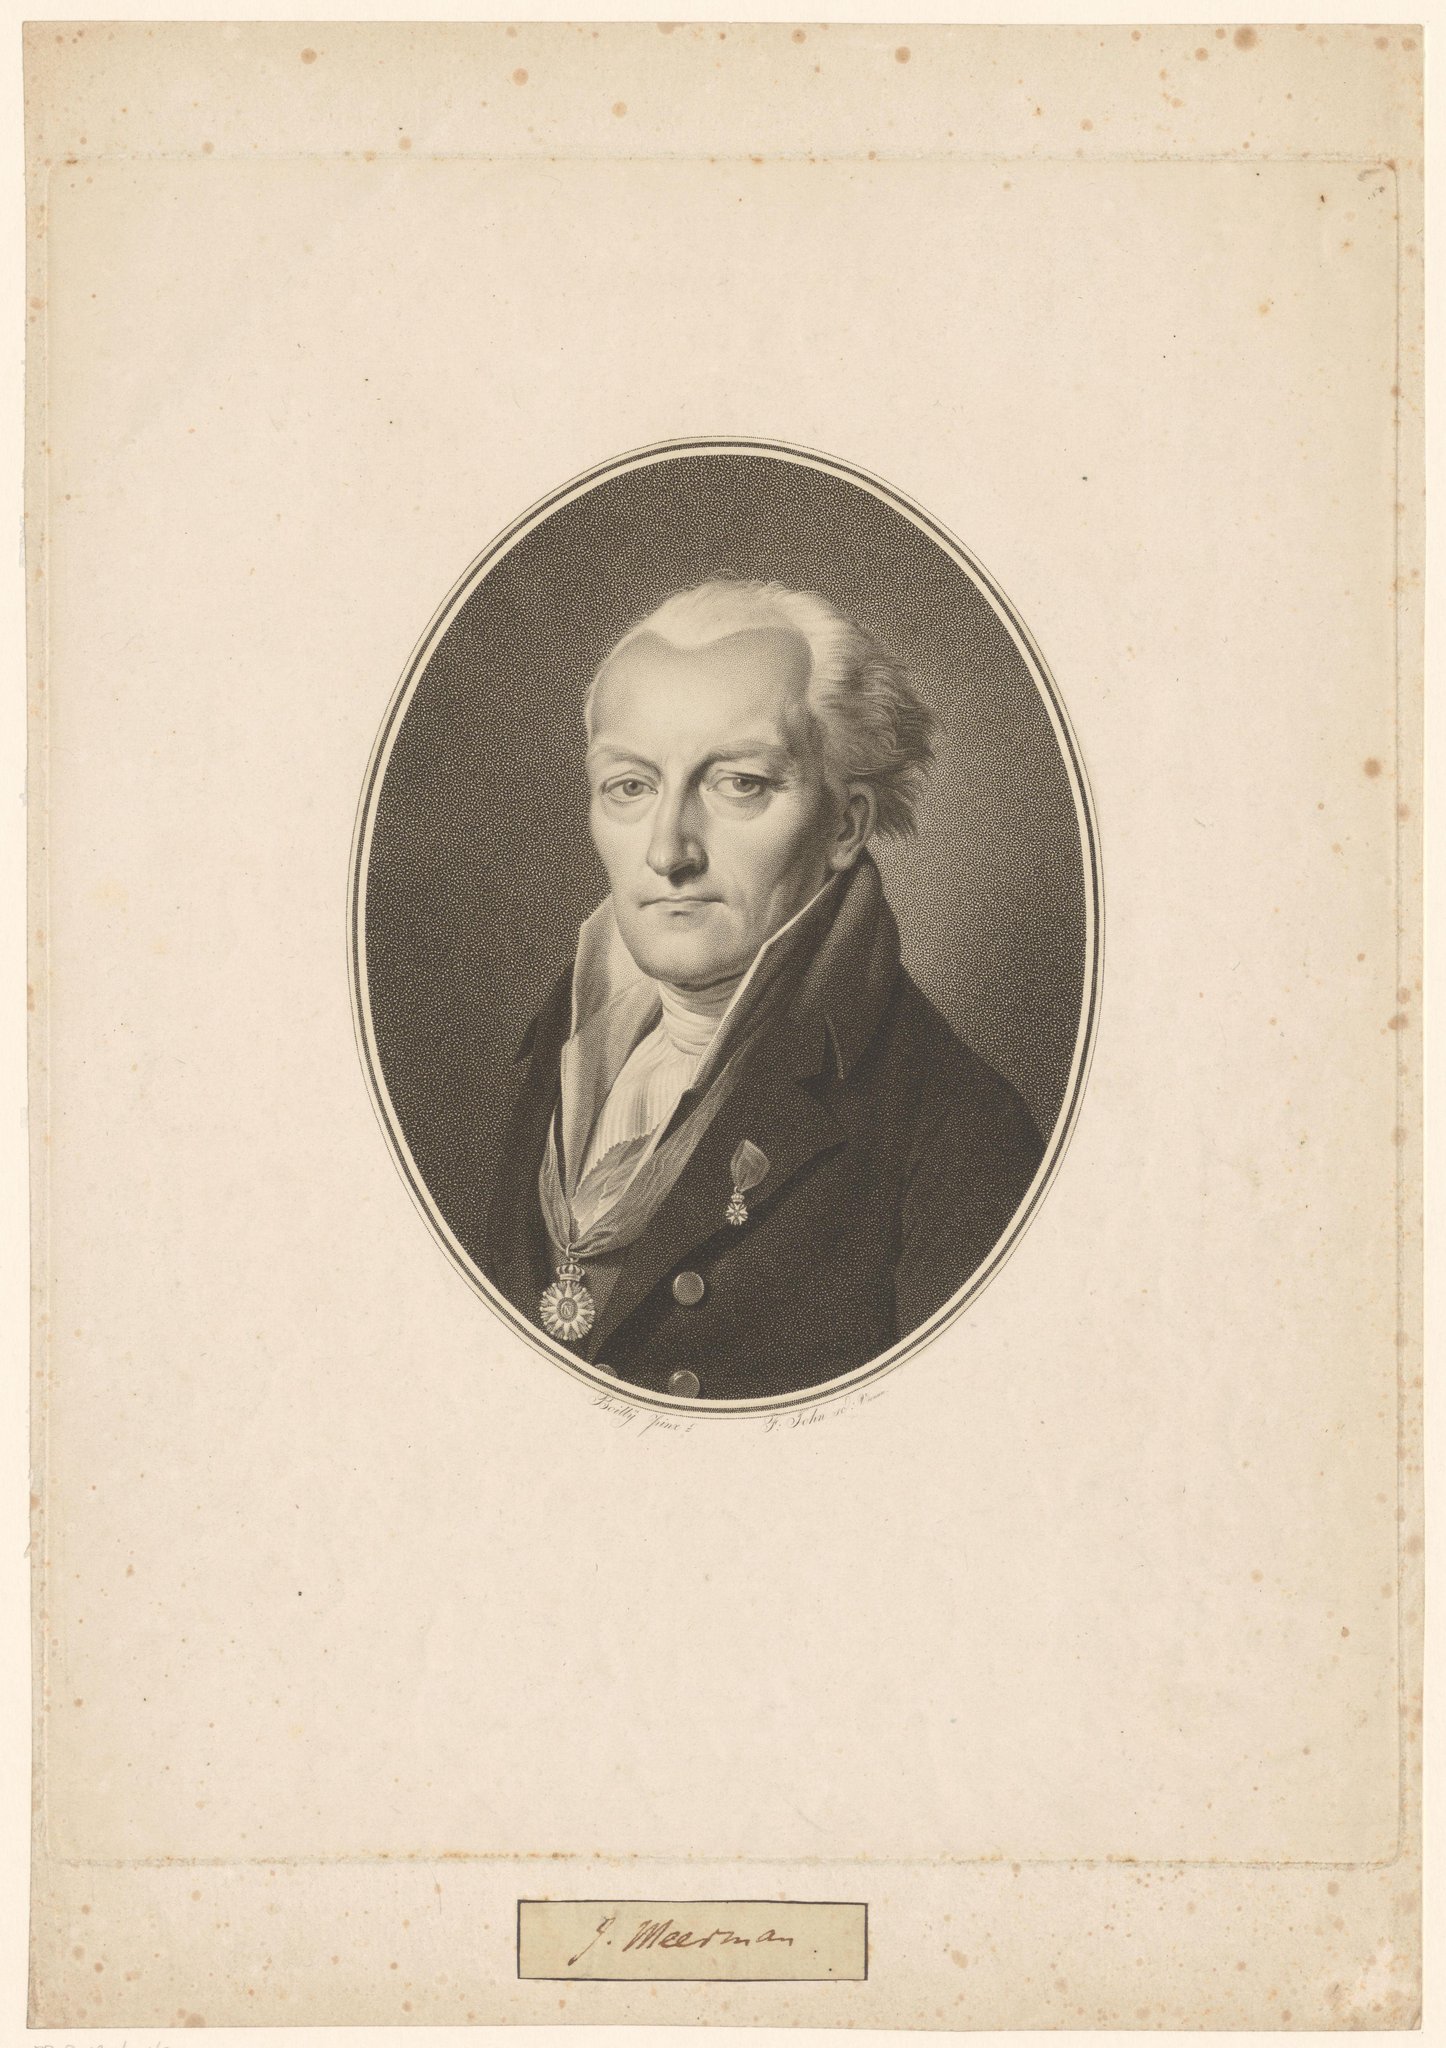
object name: print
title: Portret van Johan Meerman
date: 1779-1843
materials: paper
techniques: stippling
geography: vienna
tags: the hague, writing and letters (+ portrait of scholar, scientist), historical persons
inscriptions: collector's mark: Lugt 2228